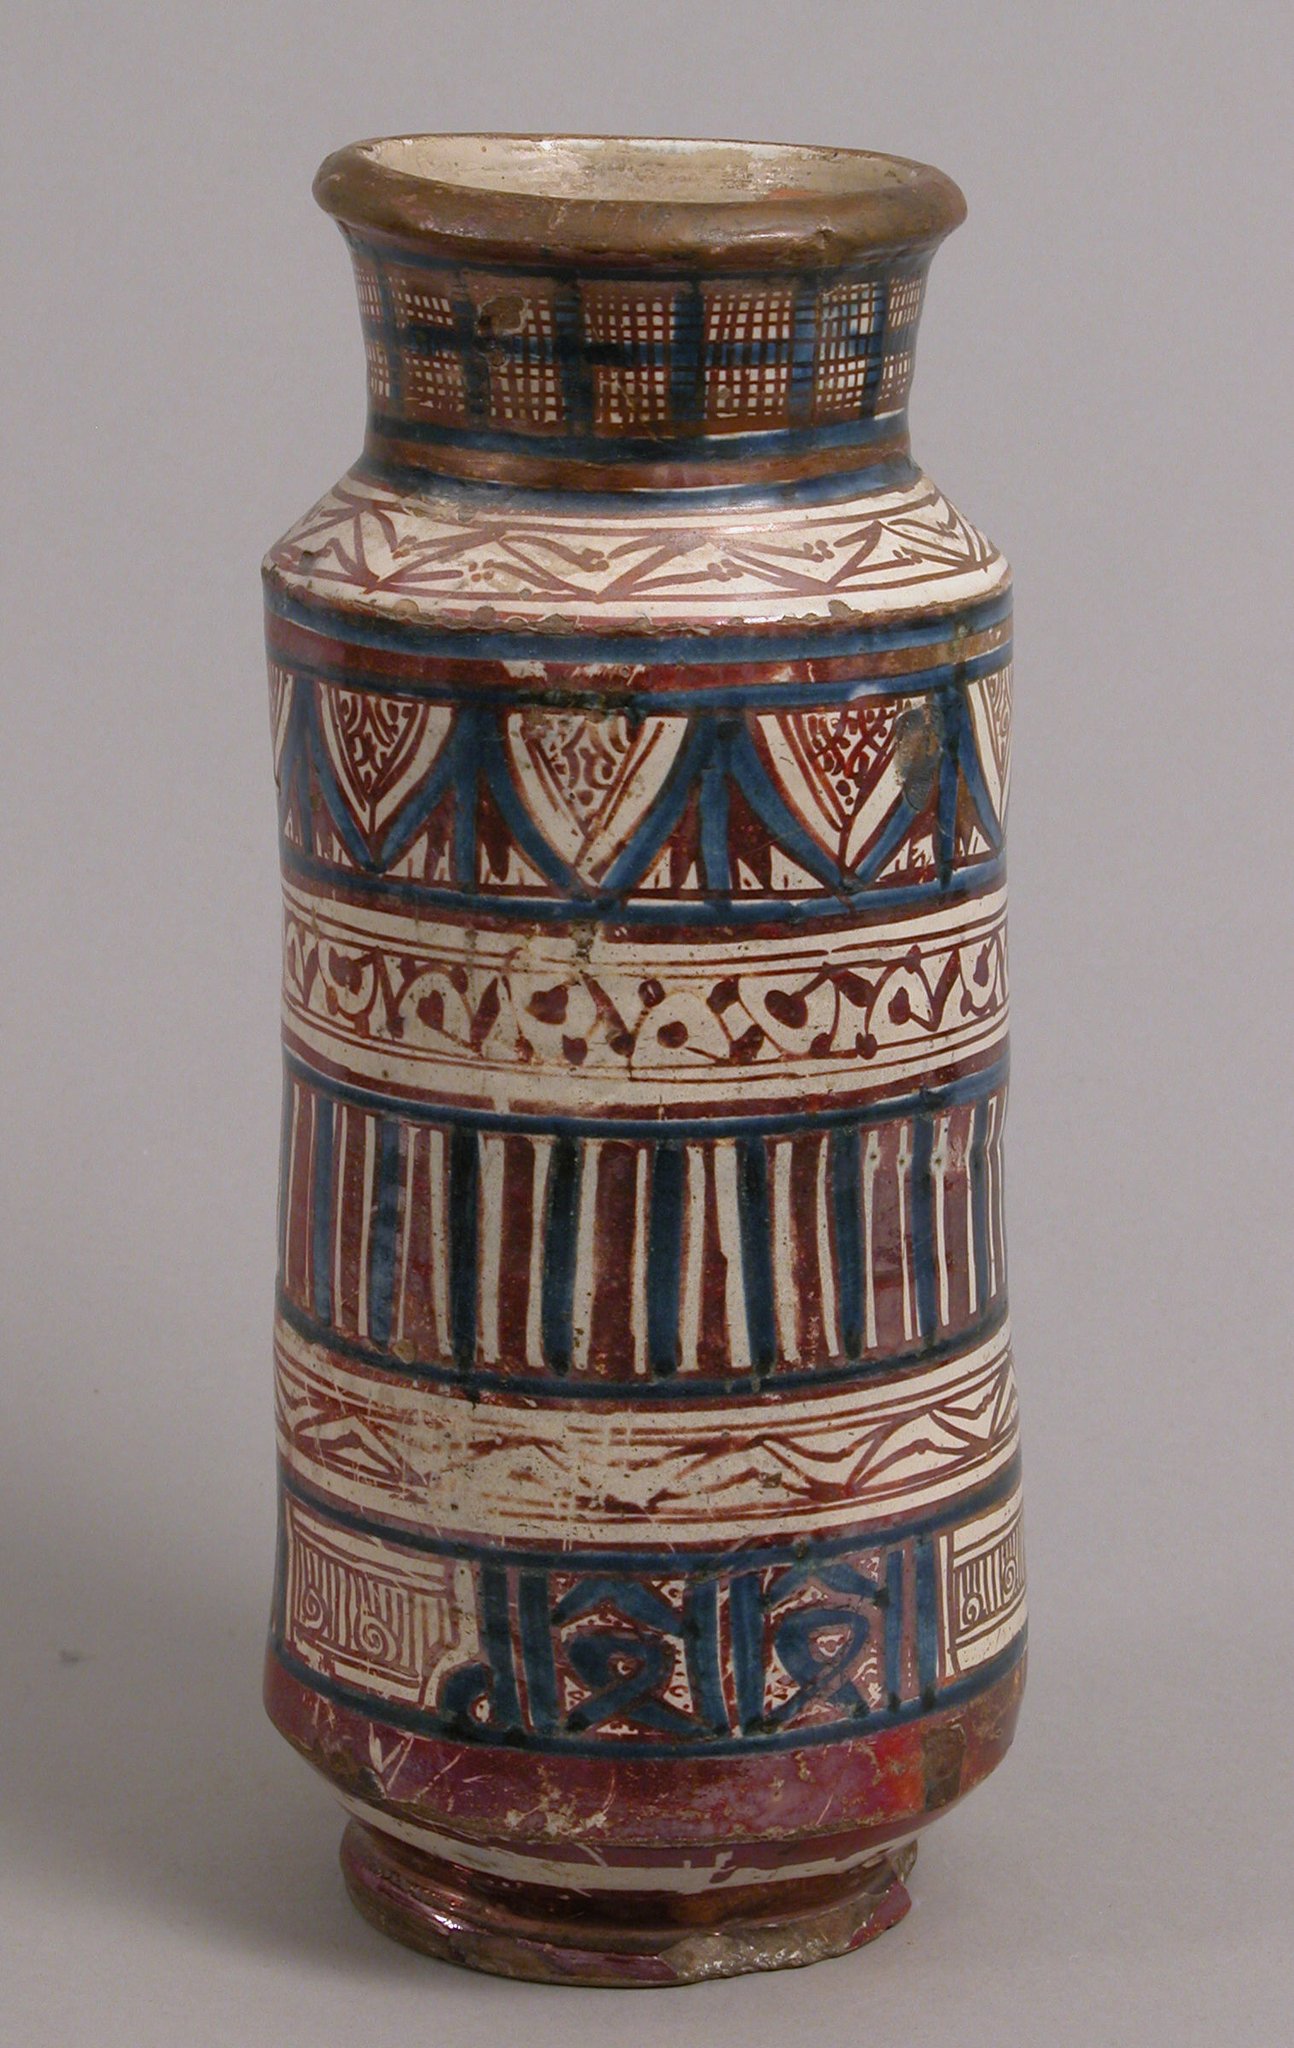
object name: pharmacy jar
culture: spanish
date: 1400-1450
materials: earthenware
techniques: glazing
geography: spain